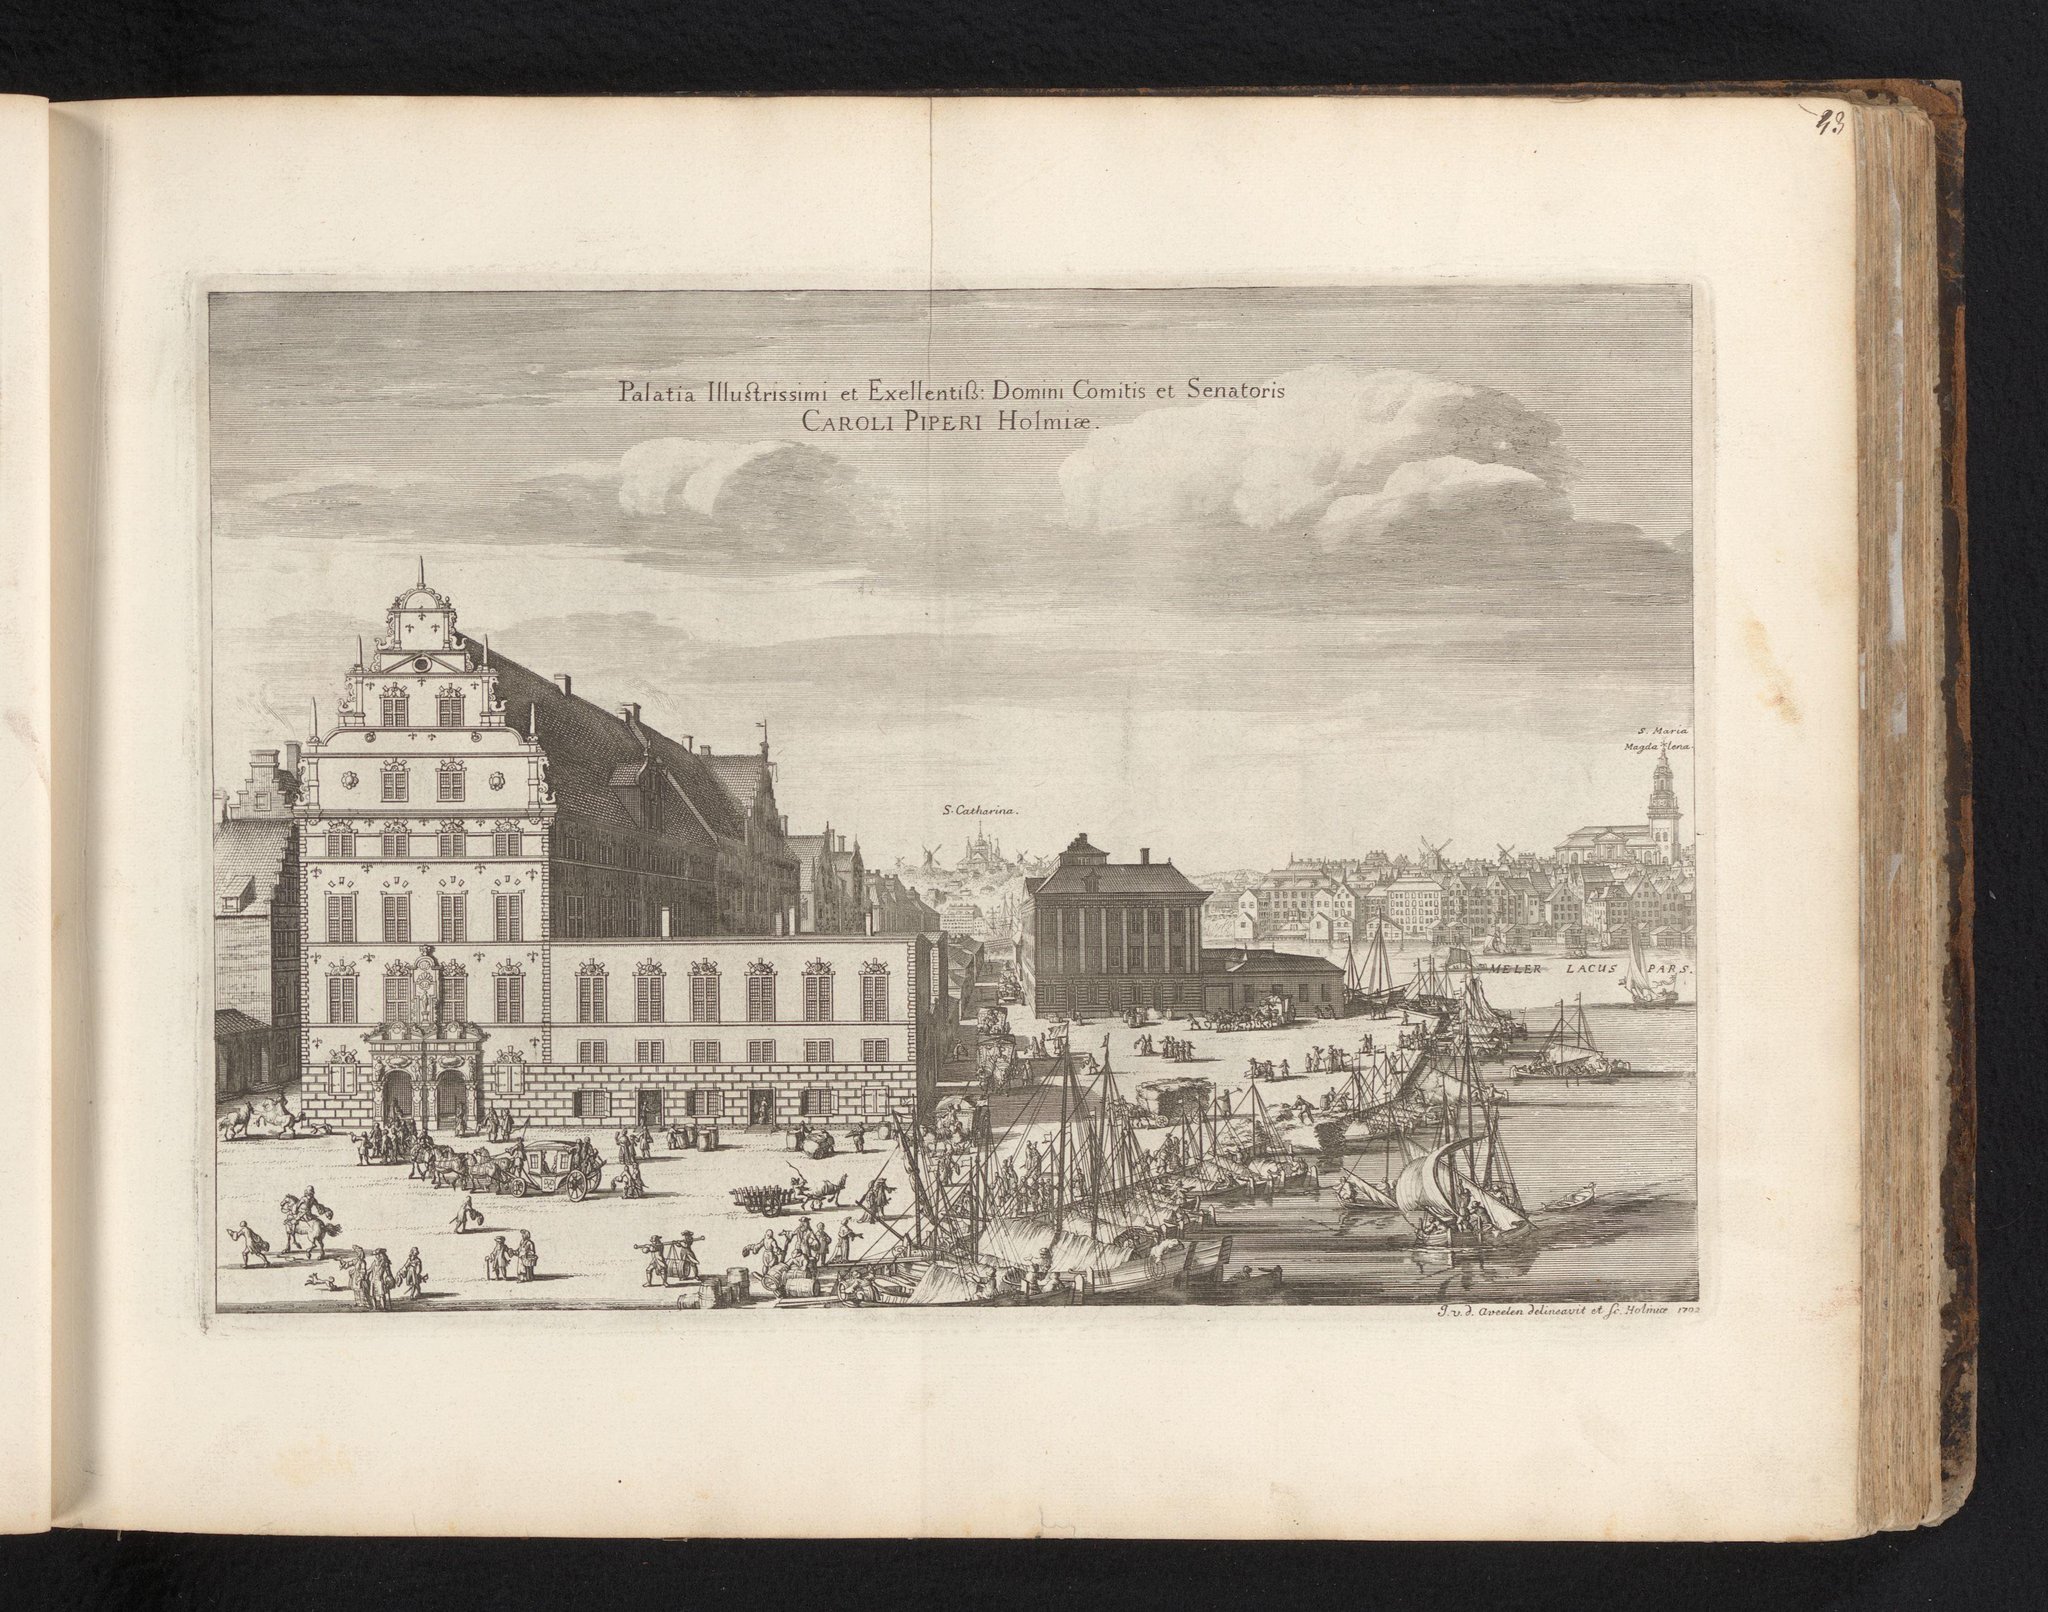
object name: album leaf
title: Paleis van Carl Pipers in Stockholm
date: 1702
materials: paper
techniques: etching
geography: stockholm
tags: palace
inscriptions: date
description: Kungliga Biblioteket, 'Suecia': http://www.kb.se/samlingarna/Kartor-bilder/Suecia-antiqua/ (geraadpleegd november 2016).